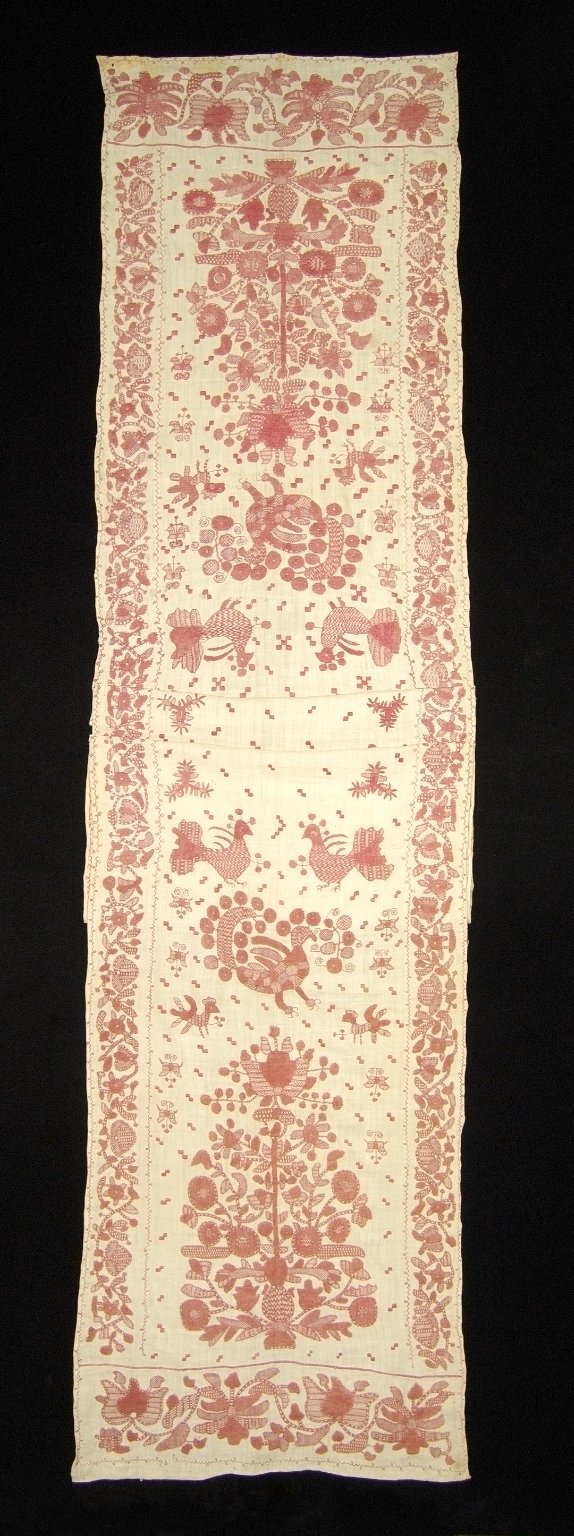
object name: textile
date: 1800-1850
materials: cotton, linen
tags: birds,flowers